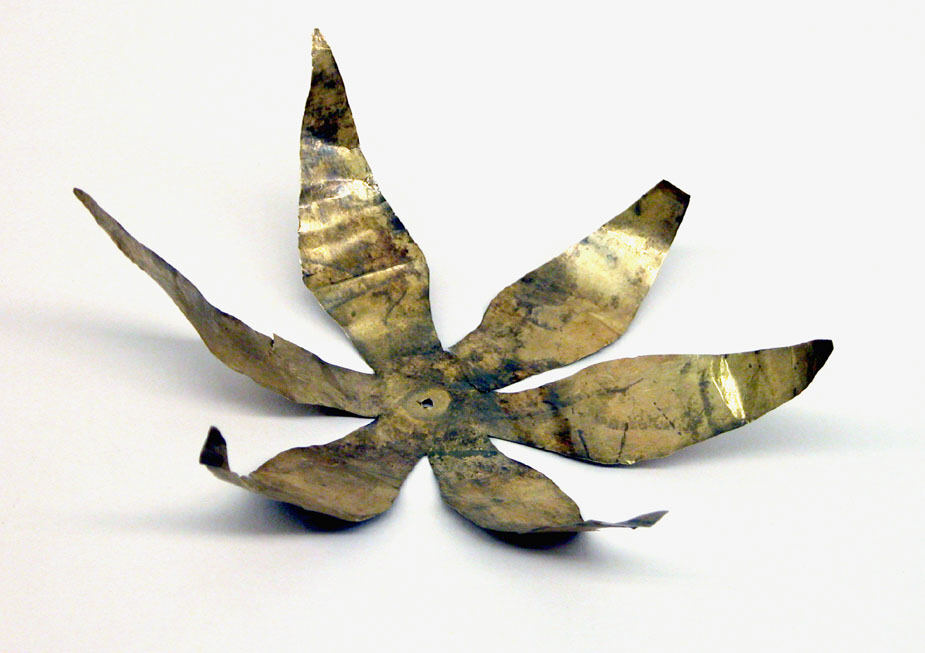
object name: base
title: Lotus Flower Base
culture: indonesian, javanese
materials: gold